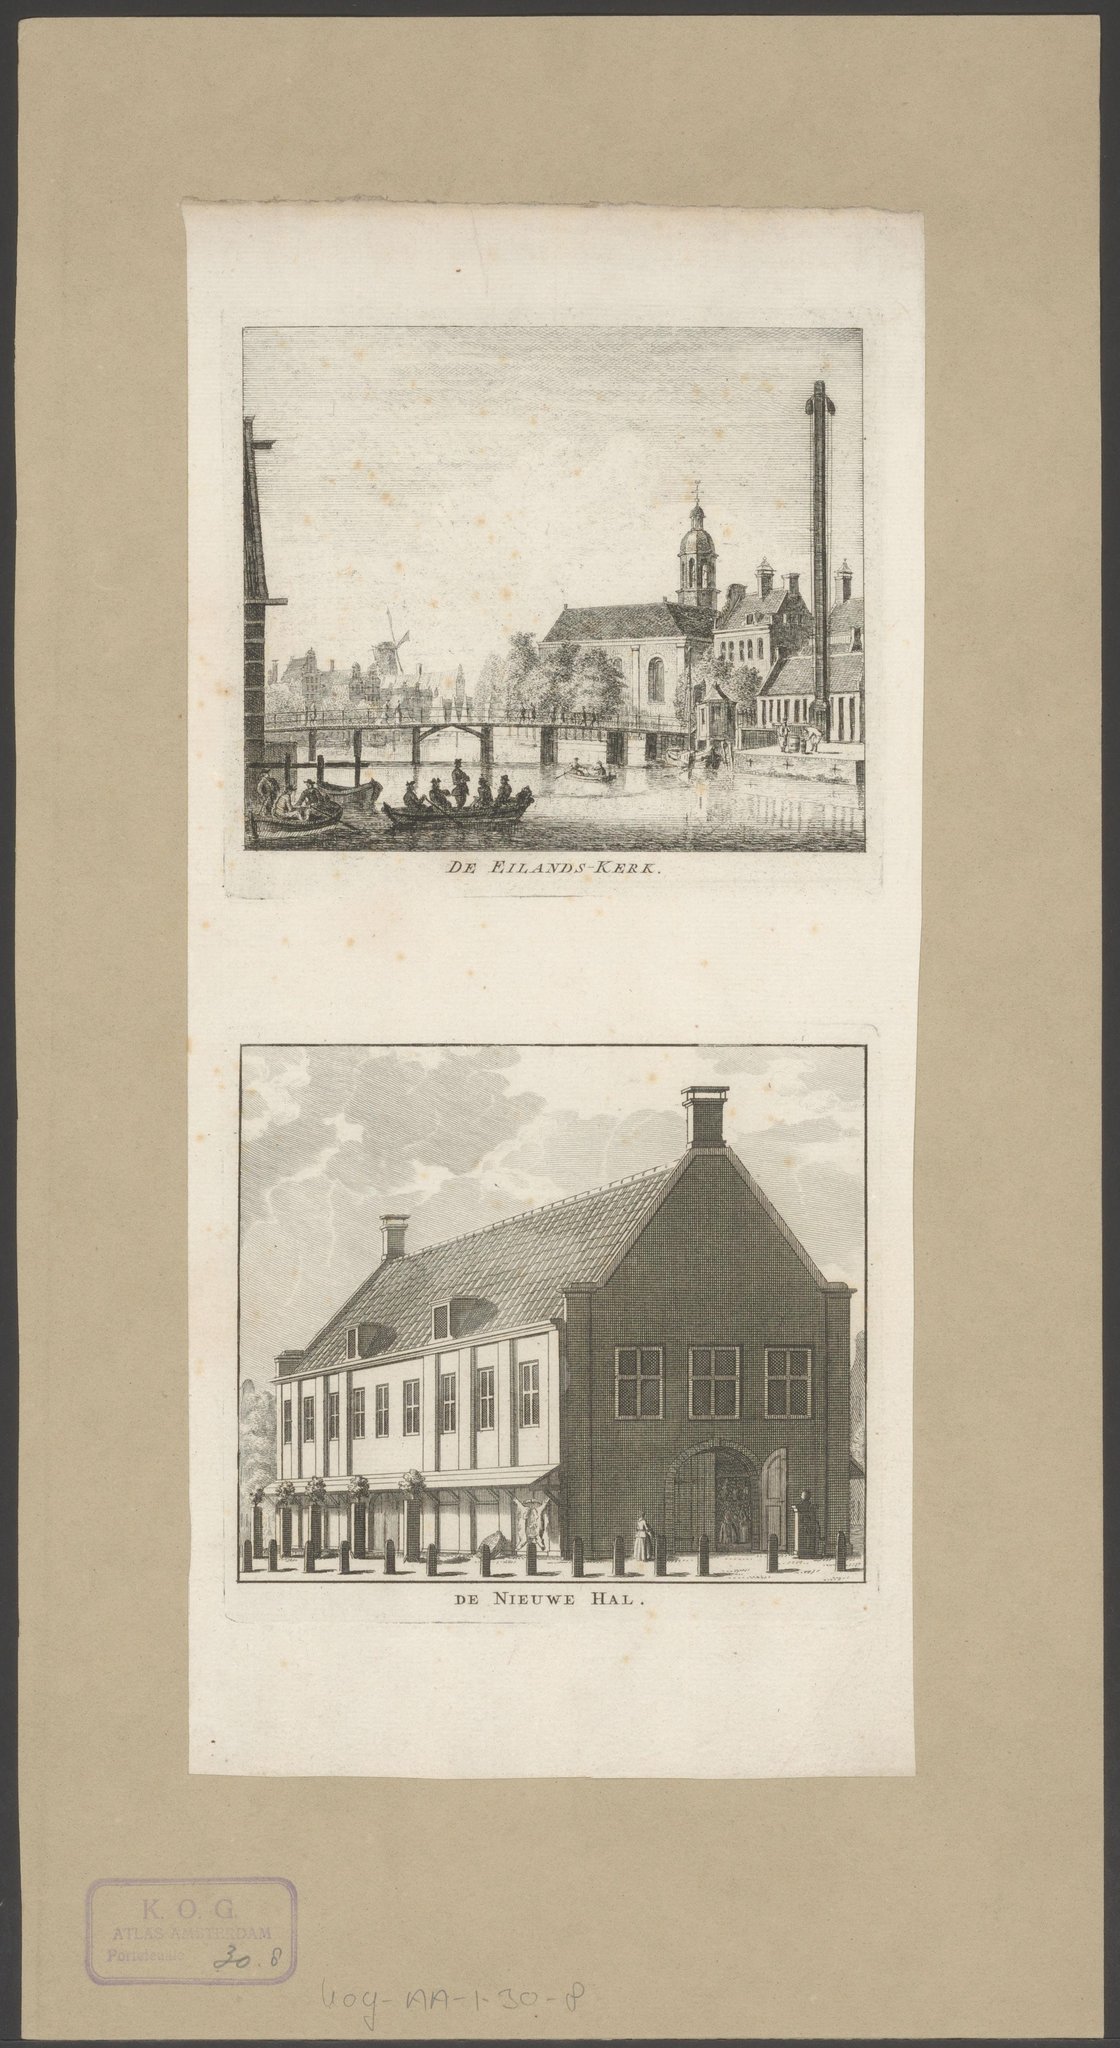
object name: print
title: De Eilands-Kerk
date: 1765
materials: paper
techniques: engraving, etching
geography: amsterdam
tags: bridge in city across river, canal, etc. (+ city(-scape) with figures, staffage), church (exterior), rowing-boat, canoe, etc., market-hall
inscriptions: collector's mark: Lugt 1641b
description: Prent mogelijk uit: Wagenaar, Jan. Amsterdam, in zyne opkomst, aanwas, geschiedenissen (…). Amsterdam: Isaak Tirion, 1765, dl. 2.